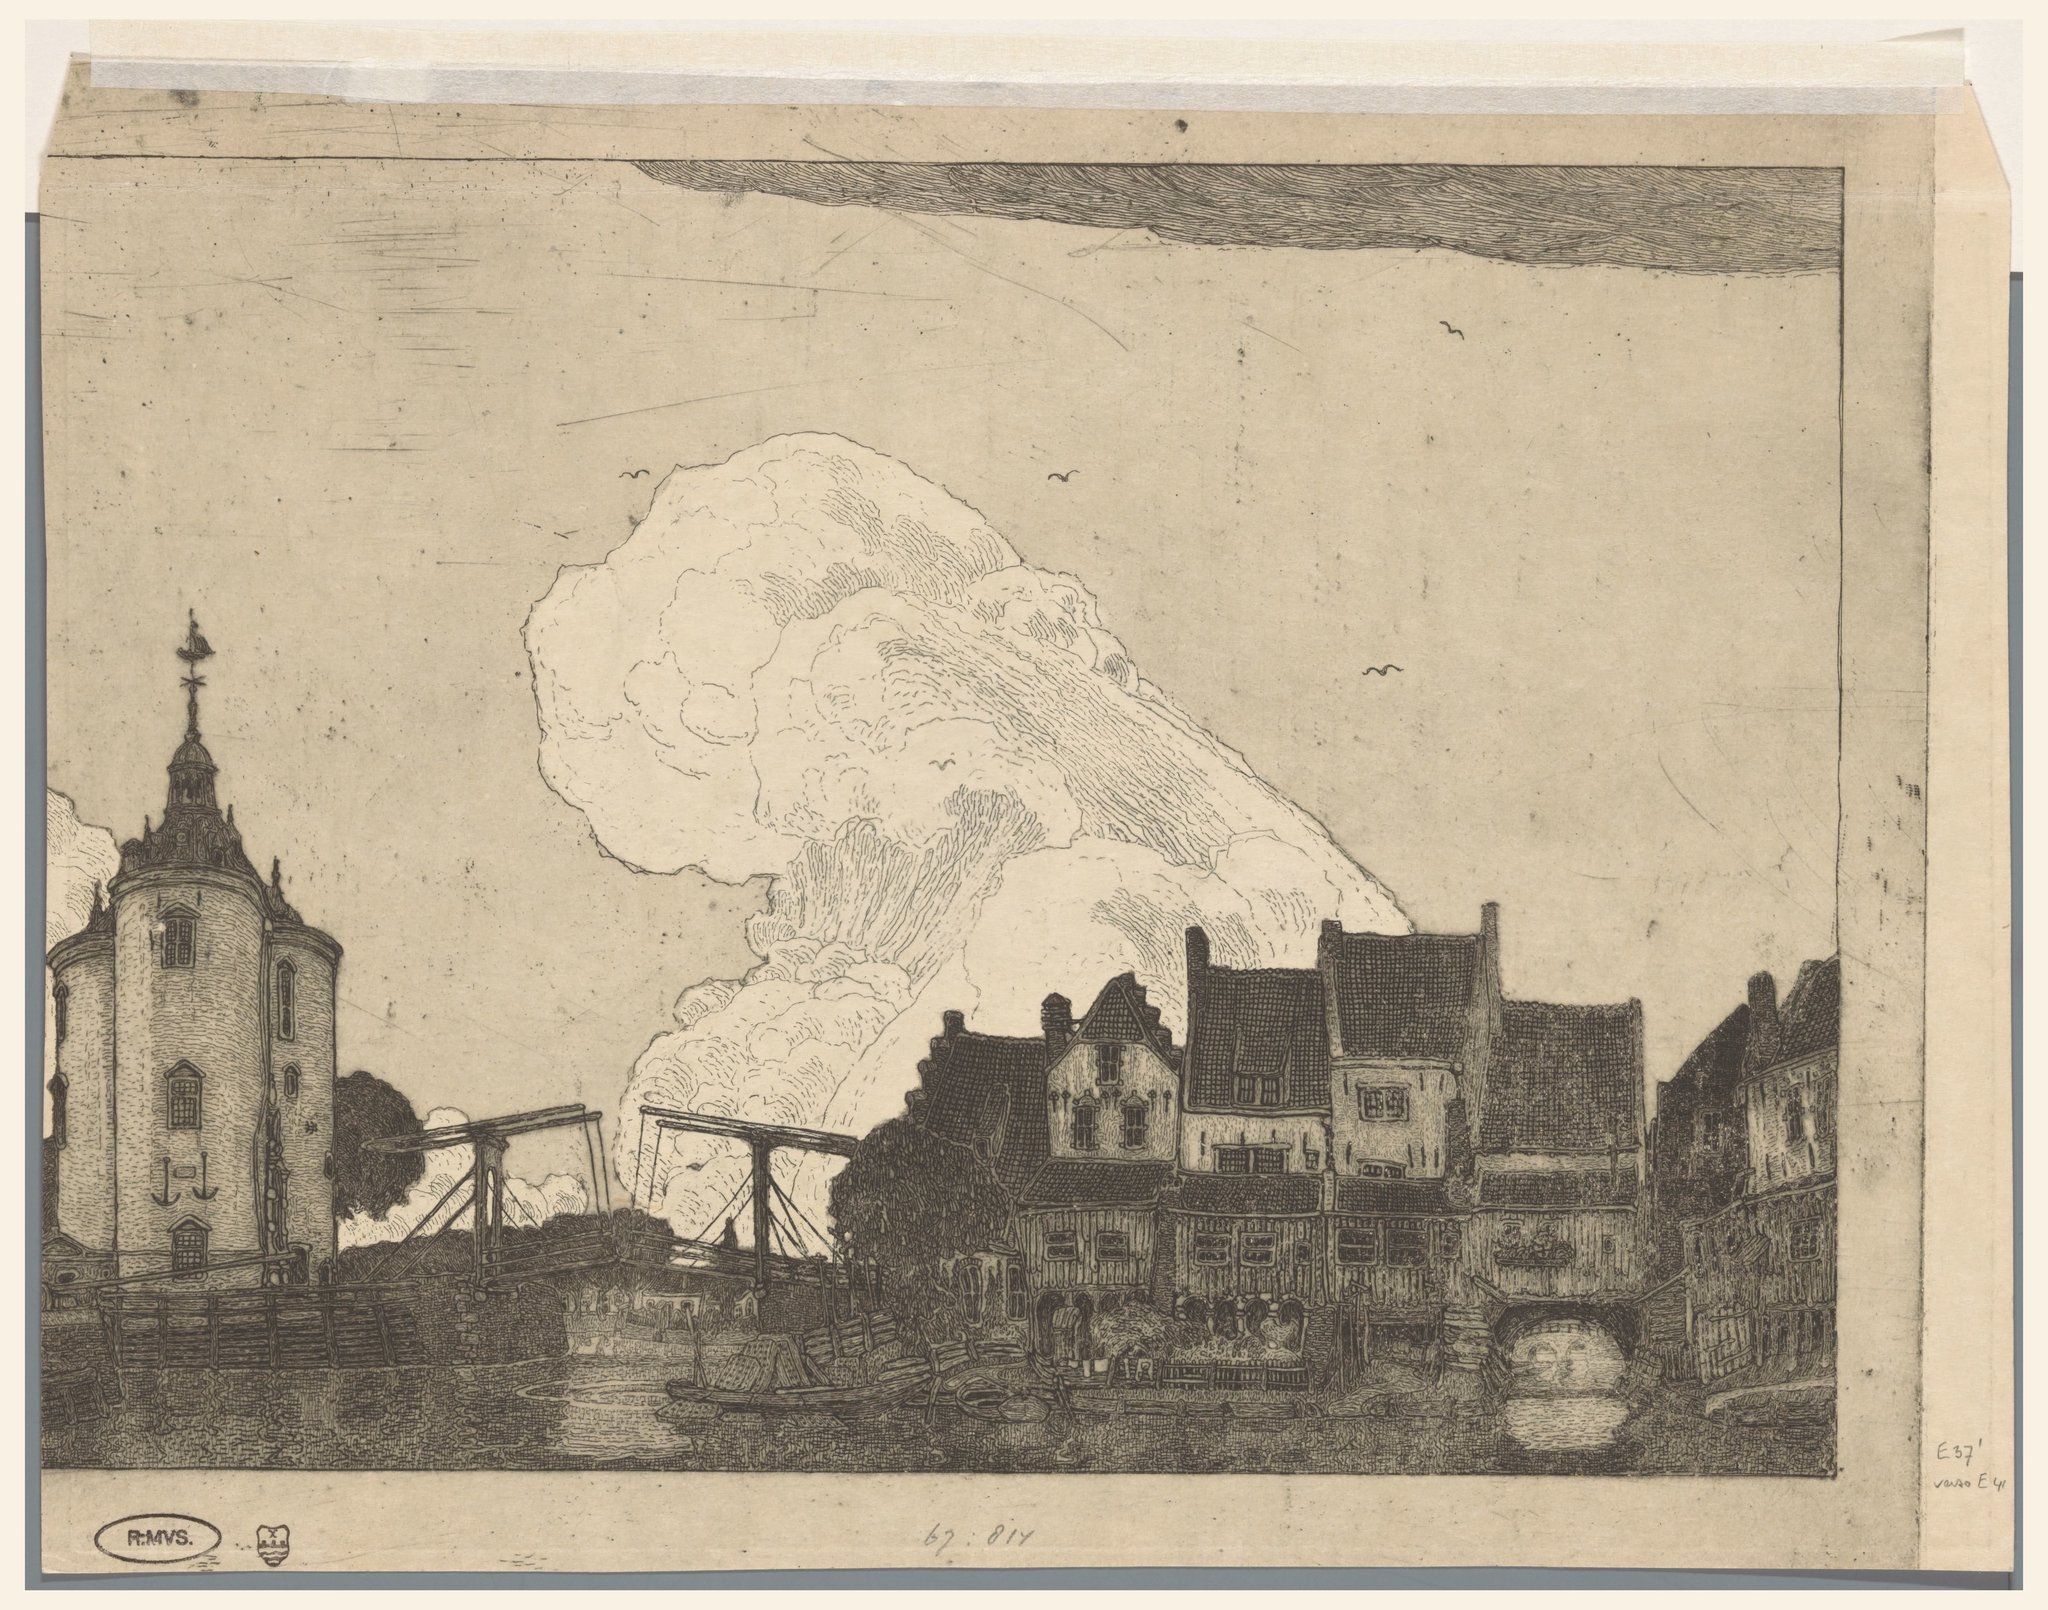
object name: print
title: Haven te Enkhuizen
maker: wijnand otto jan nieuwenkamp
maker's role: draughtsman, print maker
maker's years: 1874-1950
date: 1899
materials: paper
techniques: intaglio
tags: harbour, city-view, and landscape with man-made constructions, bridge, enkhuizen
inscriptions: collector's mark: Lugt 2228, collector's mark: Lugt 2760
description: Links de Drommedaris, de zuidelijke toegangspoort van de stad. Daarnaast een dubbele ophaalbrug die leidt naar enkele huizen, waarvan er één op een brug is gebouwd. Naast de toren en boven de huizen enkele wolken.